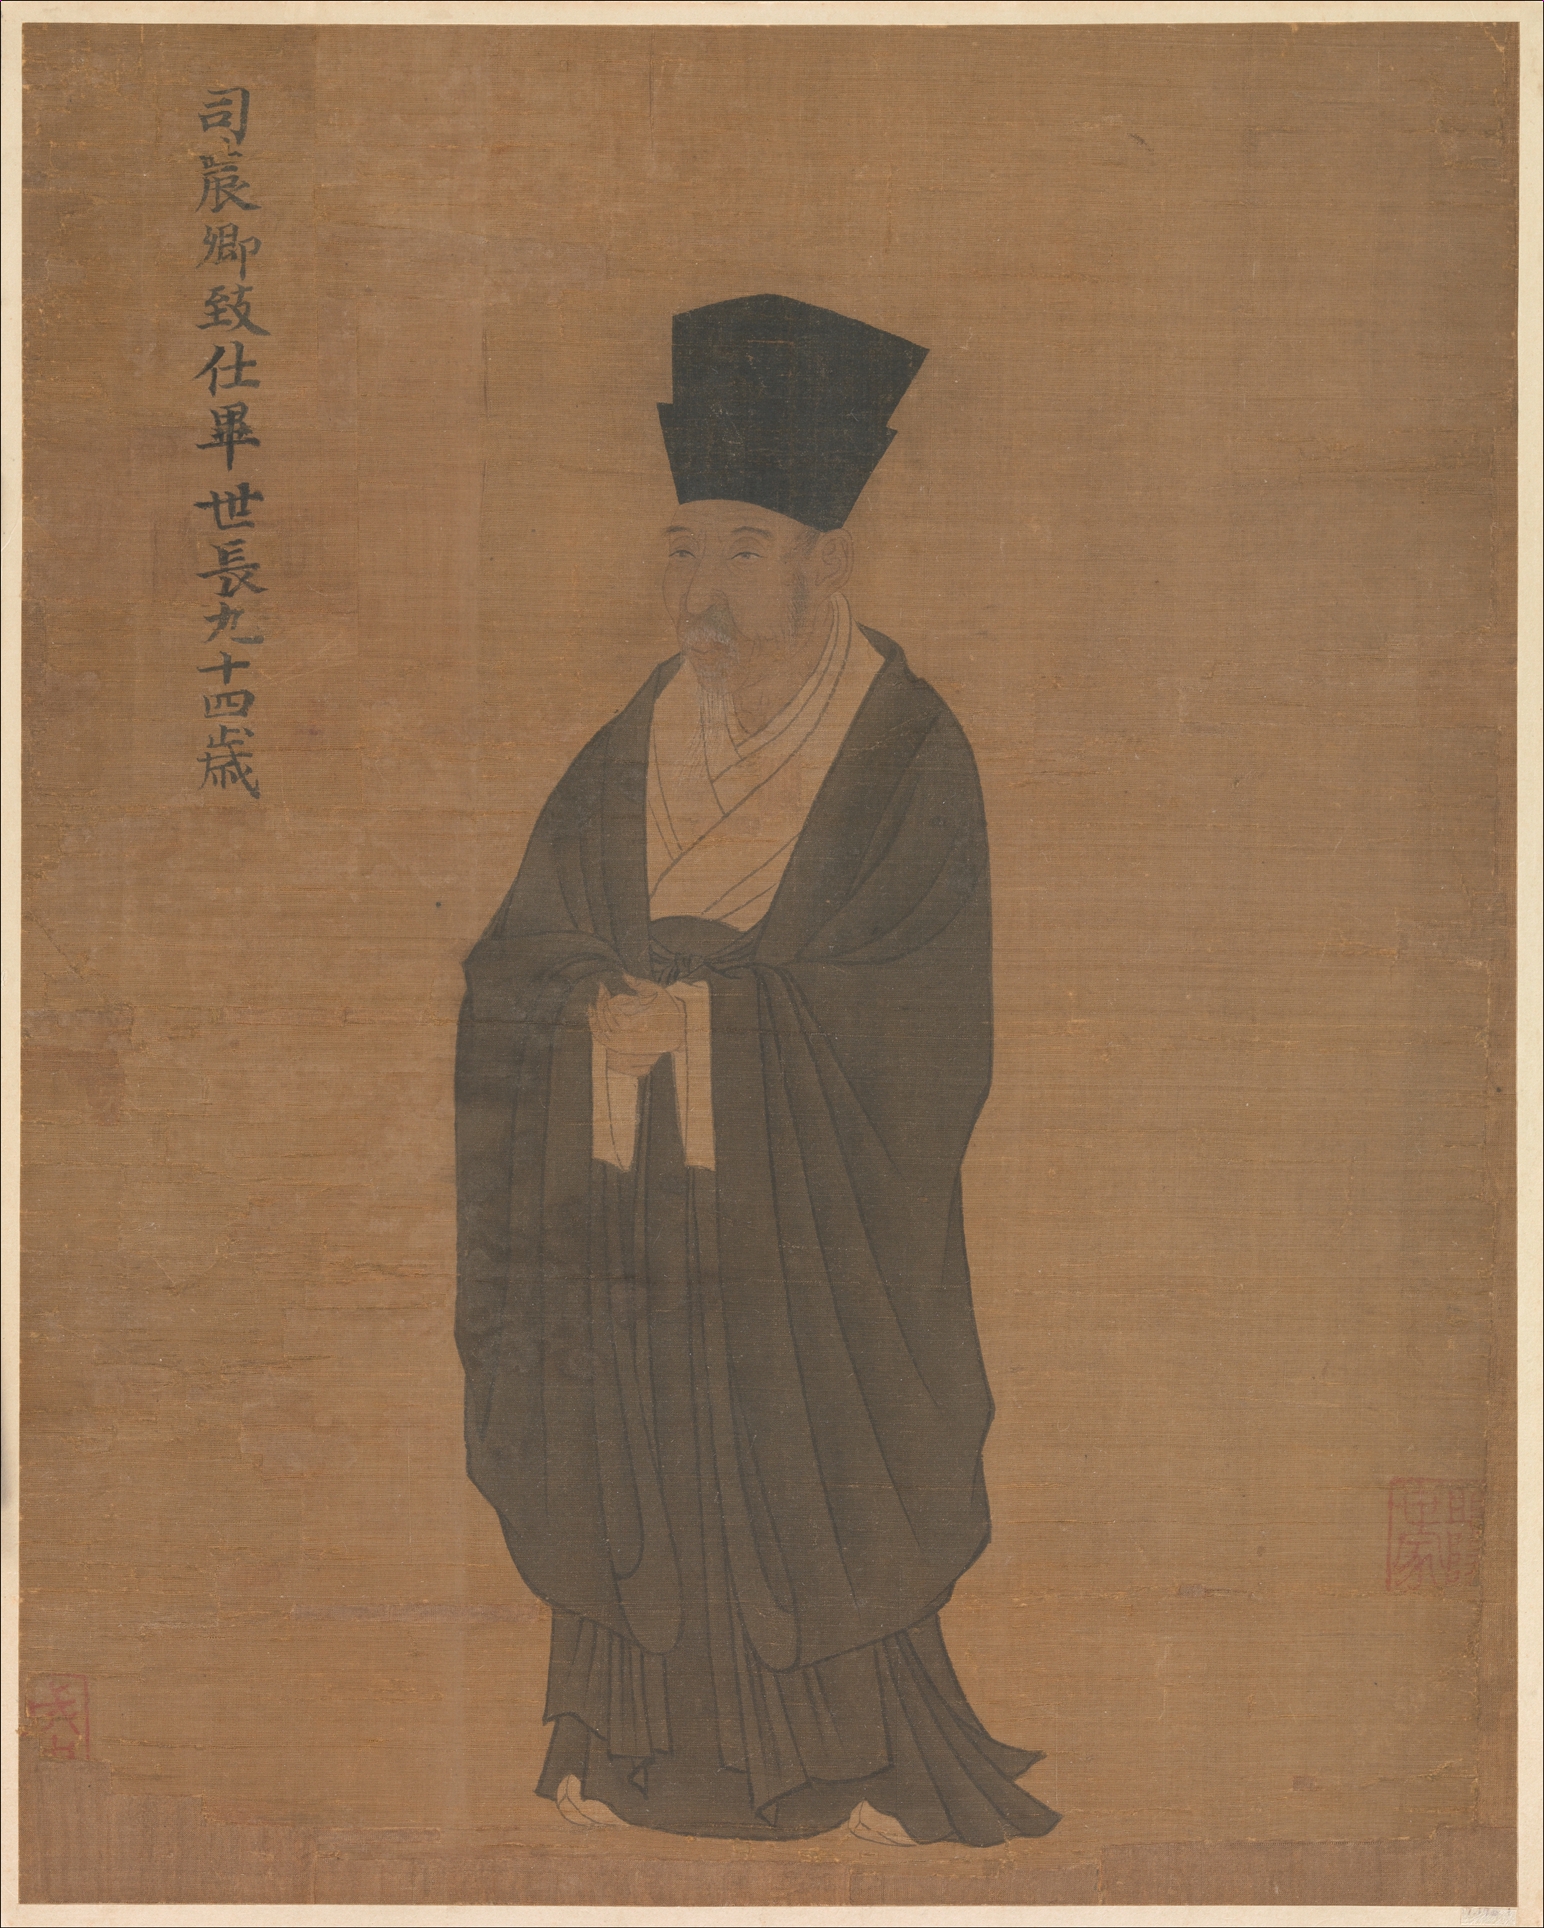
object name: album leaf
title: Portrait of Bi Shichang, from the set Five Old Men of Suiyang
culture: chinese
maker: unidentified artist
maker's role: artist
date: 1056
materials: ink, silk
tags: men,portraits